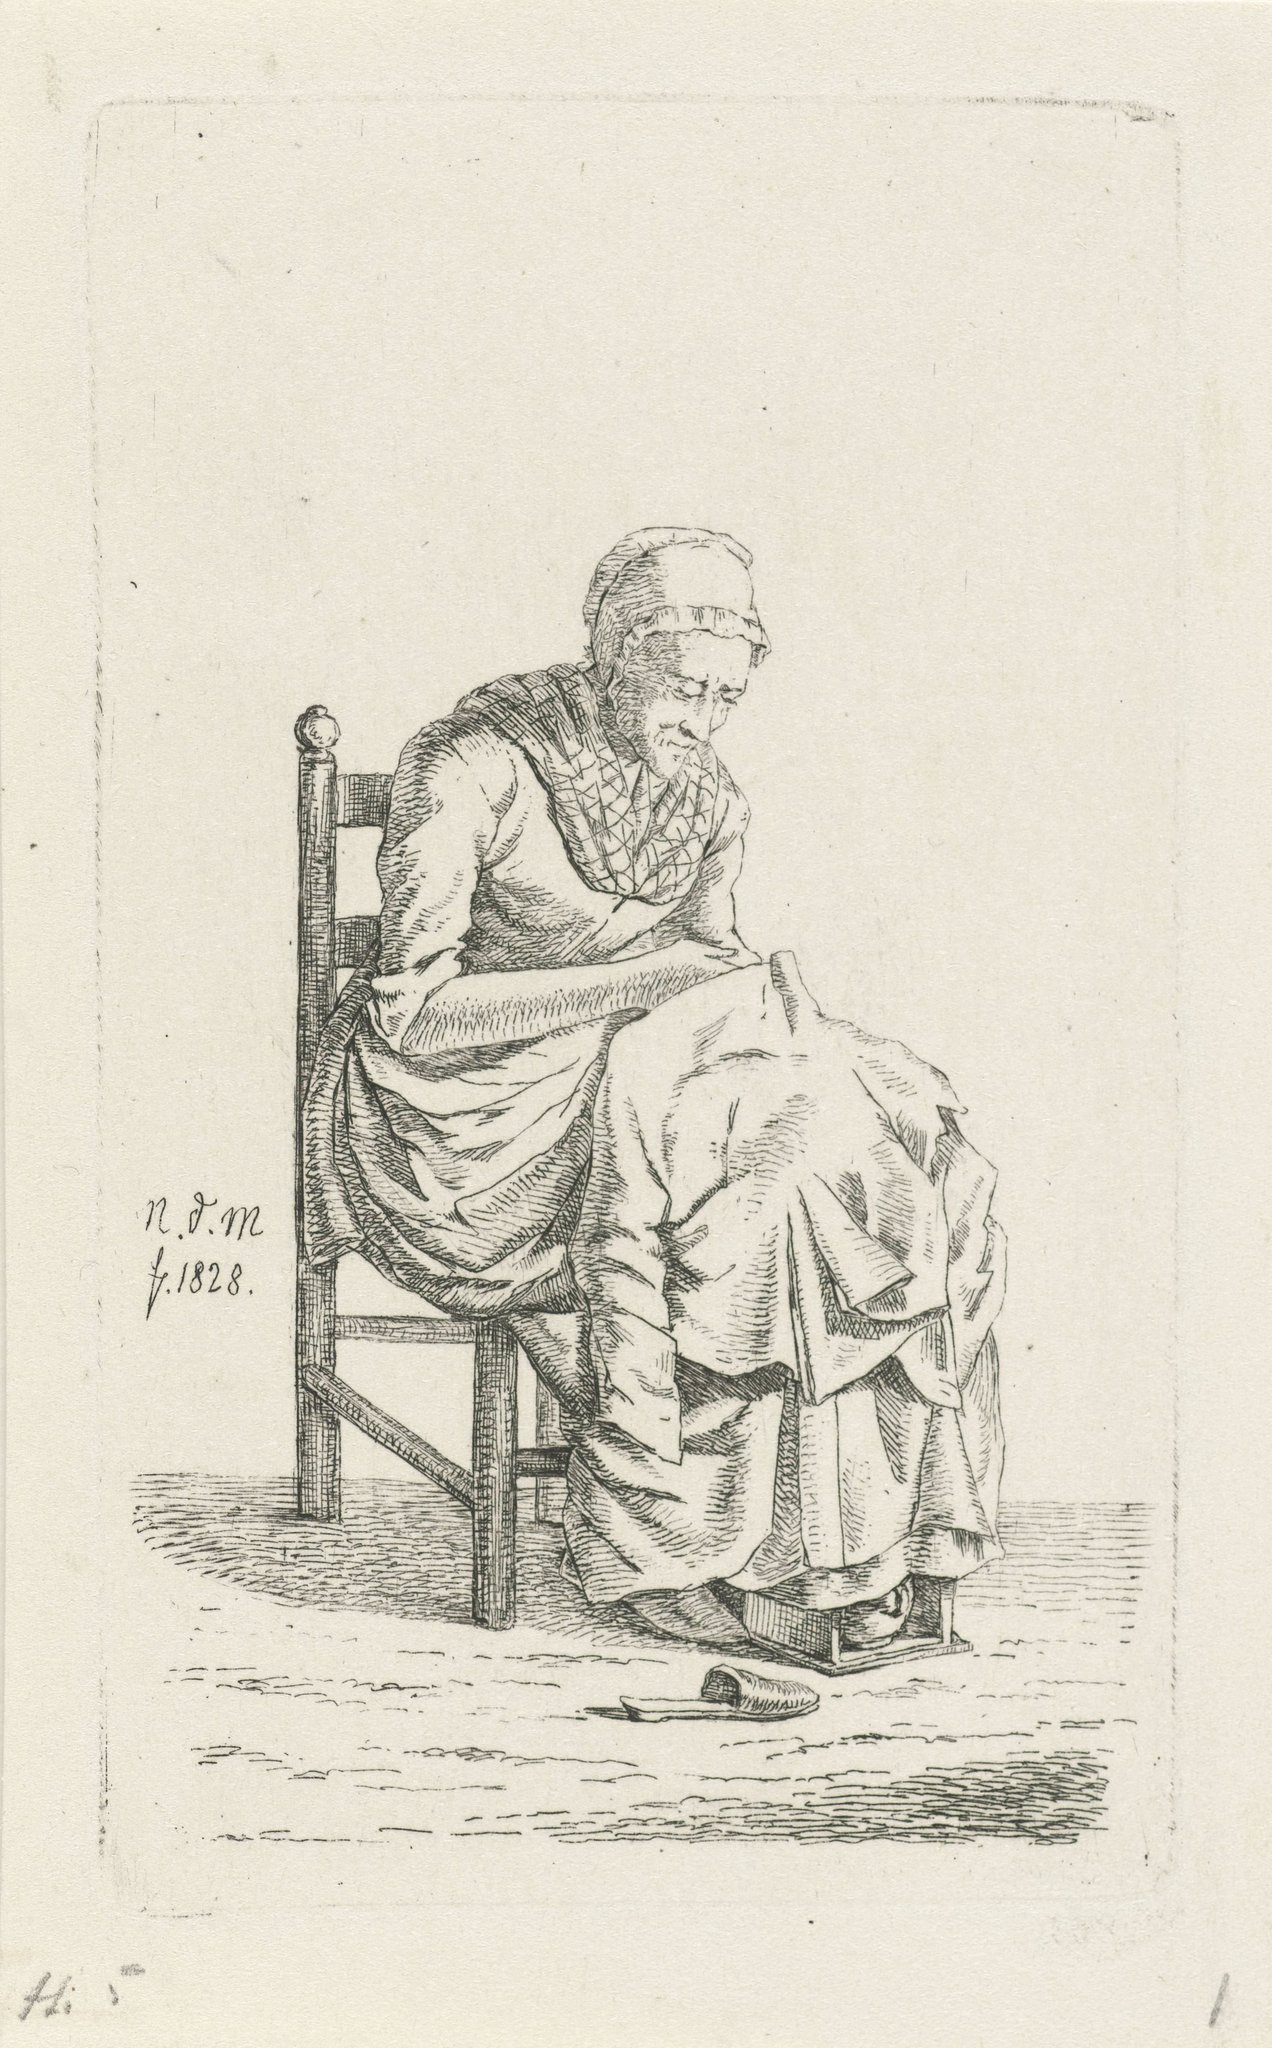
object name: print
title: 12 Studie-beeldjes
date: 1828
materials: paper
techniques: etching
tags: mending, repairing ~ clothes, sitting figure - aa - female human figure, chair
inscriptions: collector's mark: Lugt 2228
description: Een vrouw zittend op een stoel, terwijl ze een kledingstuk verstelt. Haar voet op een stoofje. Prent uit een serie van twaalf prenten met studies van menselijke figuren.